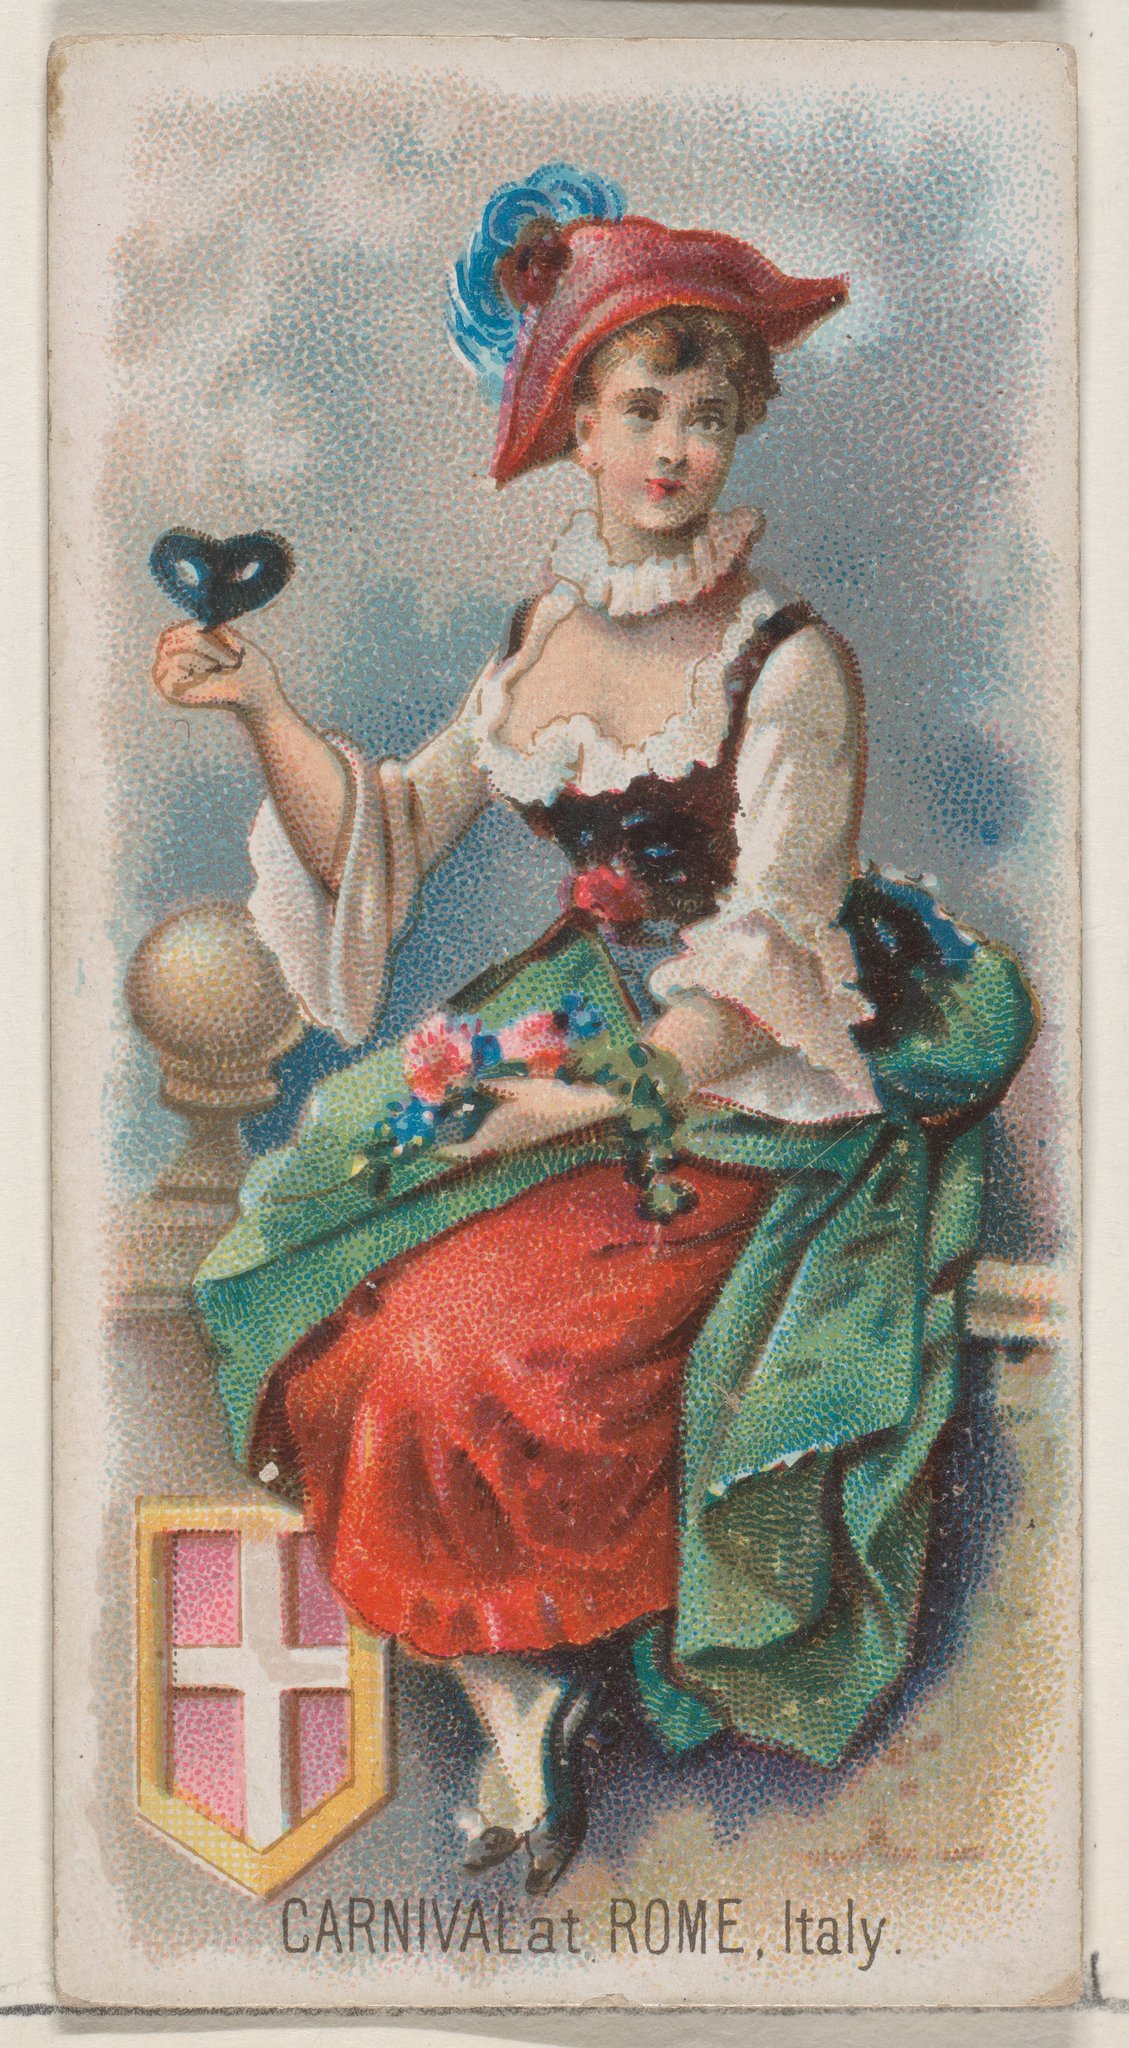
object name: print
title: Carnival at Rome, Italy, from the Holidays series (N80) for Duke brand cigarettes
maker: w. duke, sons & co.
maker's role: publisher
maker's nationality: american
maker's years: 1870-1920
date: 1890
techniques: color lithograph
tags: women